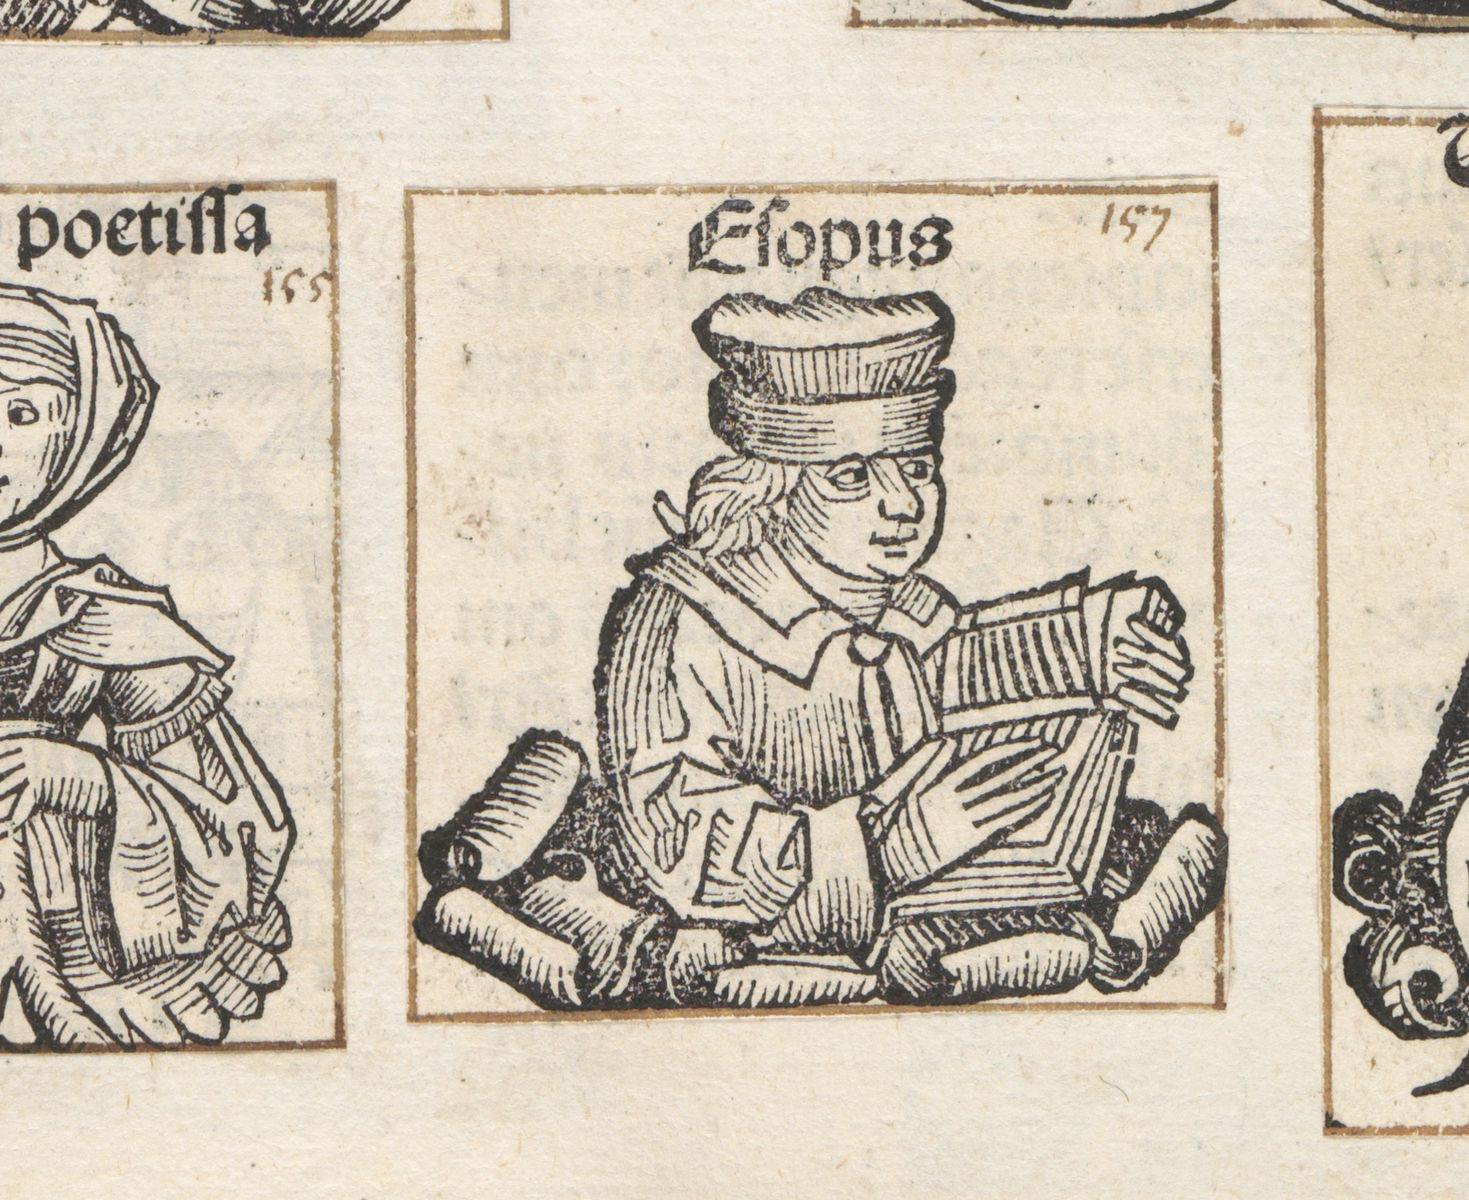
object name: print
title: Aesopus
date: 1493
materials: paper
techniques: letterpress printing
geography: nuremberg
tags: aesopus, reading, male persons from classical history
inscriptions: inscription: ‘157’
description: De houtsnede wordt gebruikt als boekillustratie in de Liber Chronicarum (of Neurenbergkroniek) van Hartmann Schedel, verschenen in het Latijn en Duits in 1493. Zie de Latijnse uitgave, folio 70r.